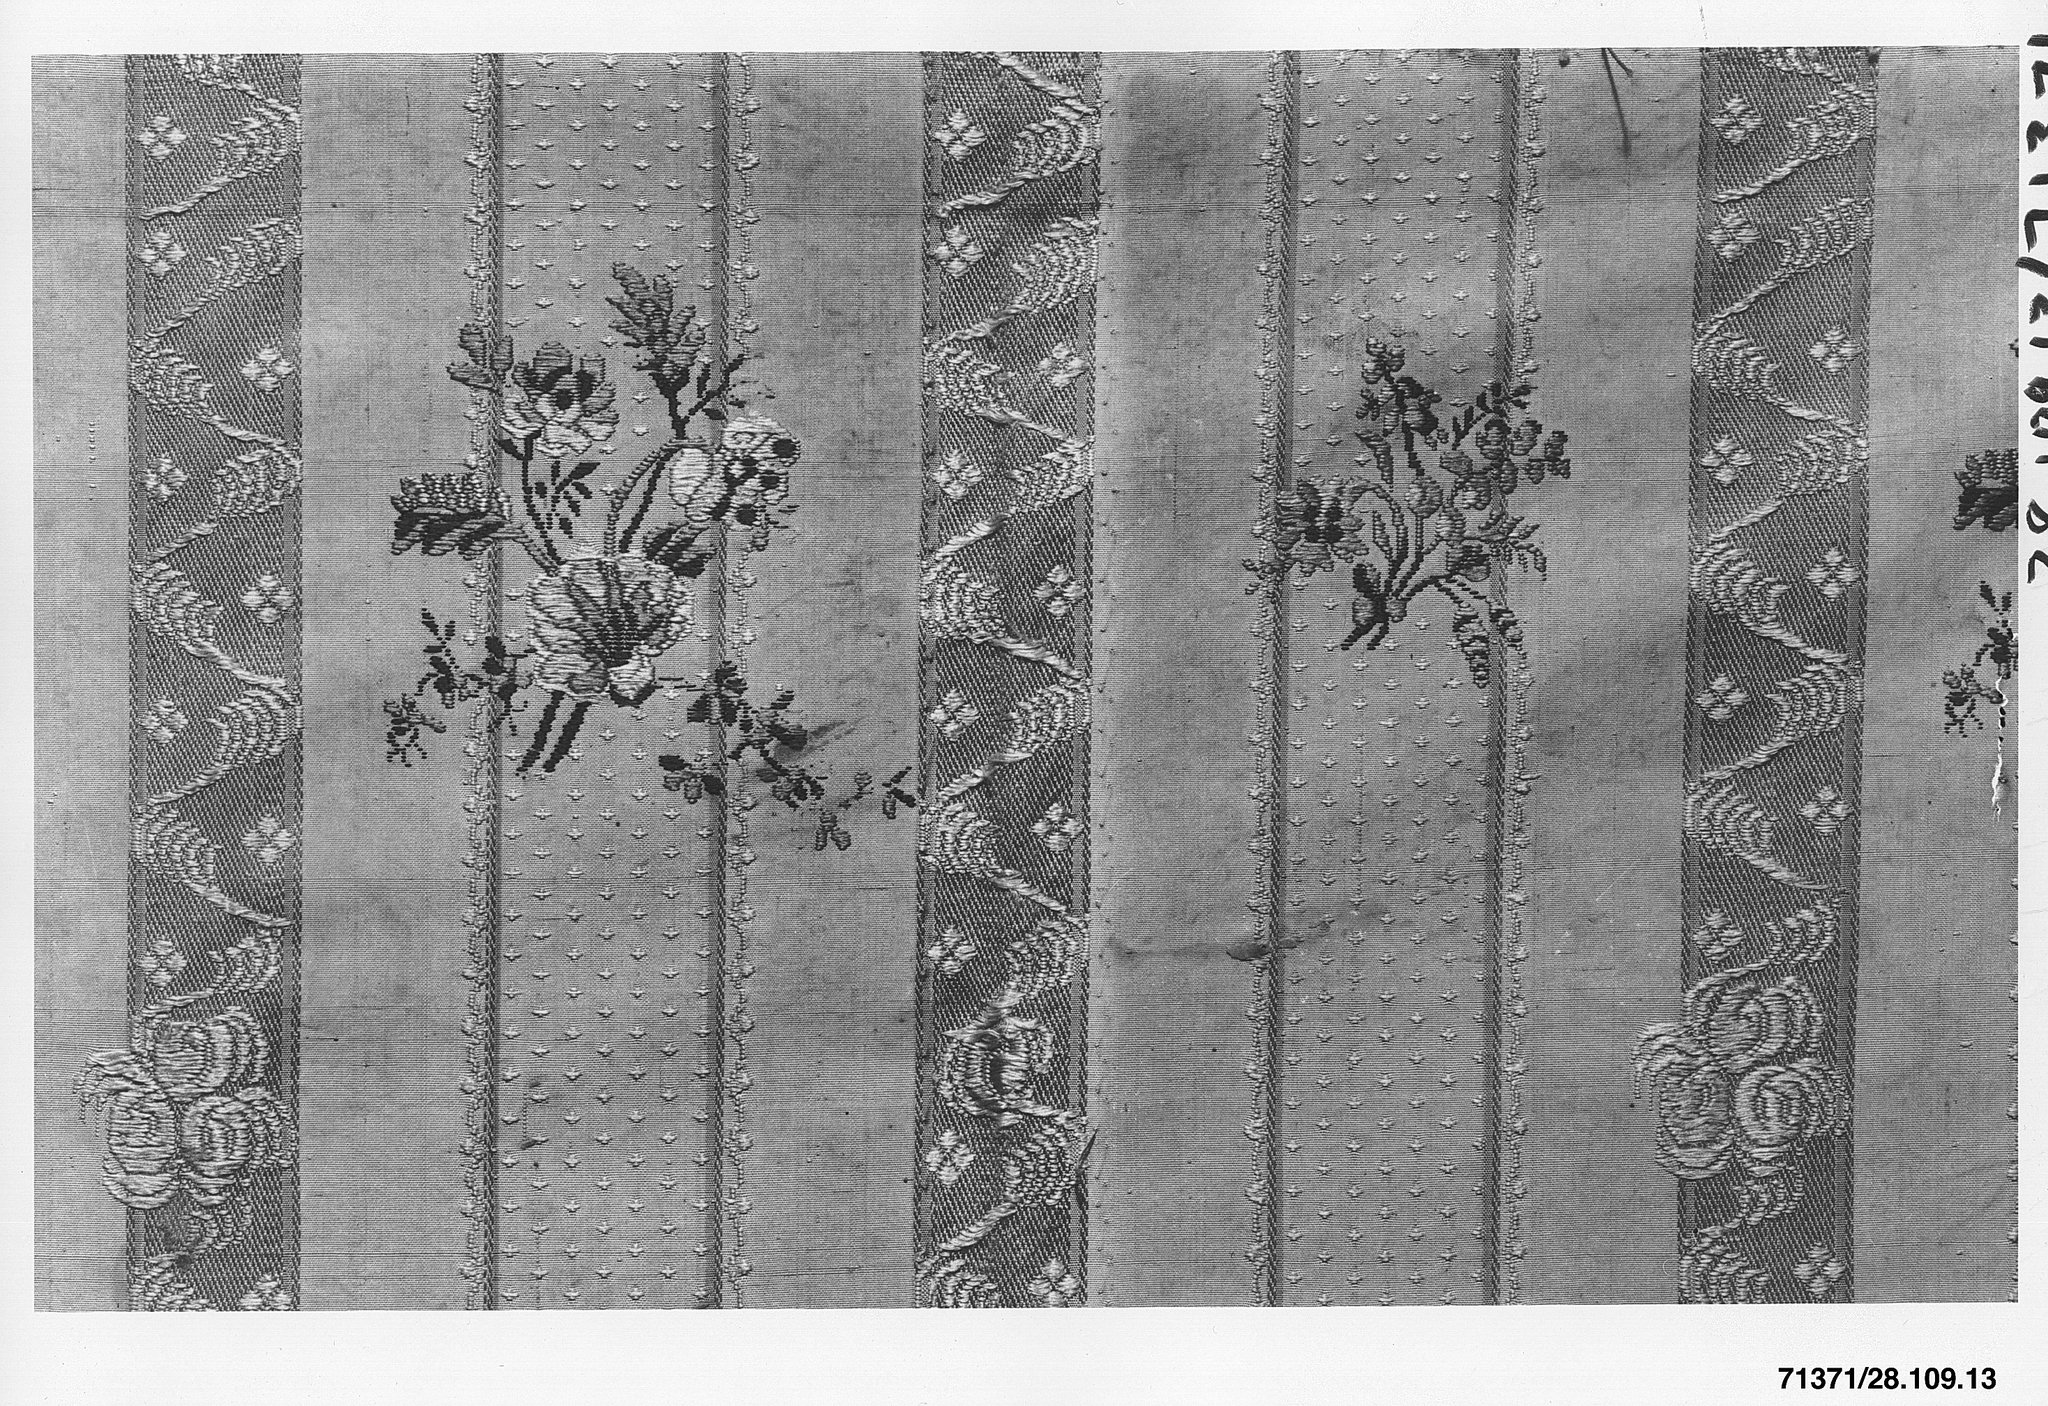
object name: fragment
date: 1834-1866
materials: silk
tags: flowers,leaves